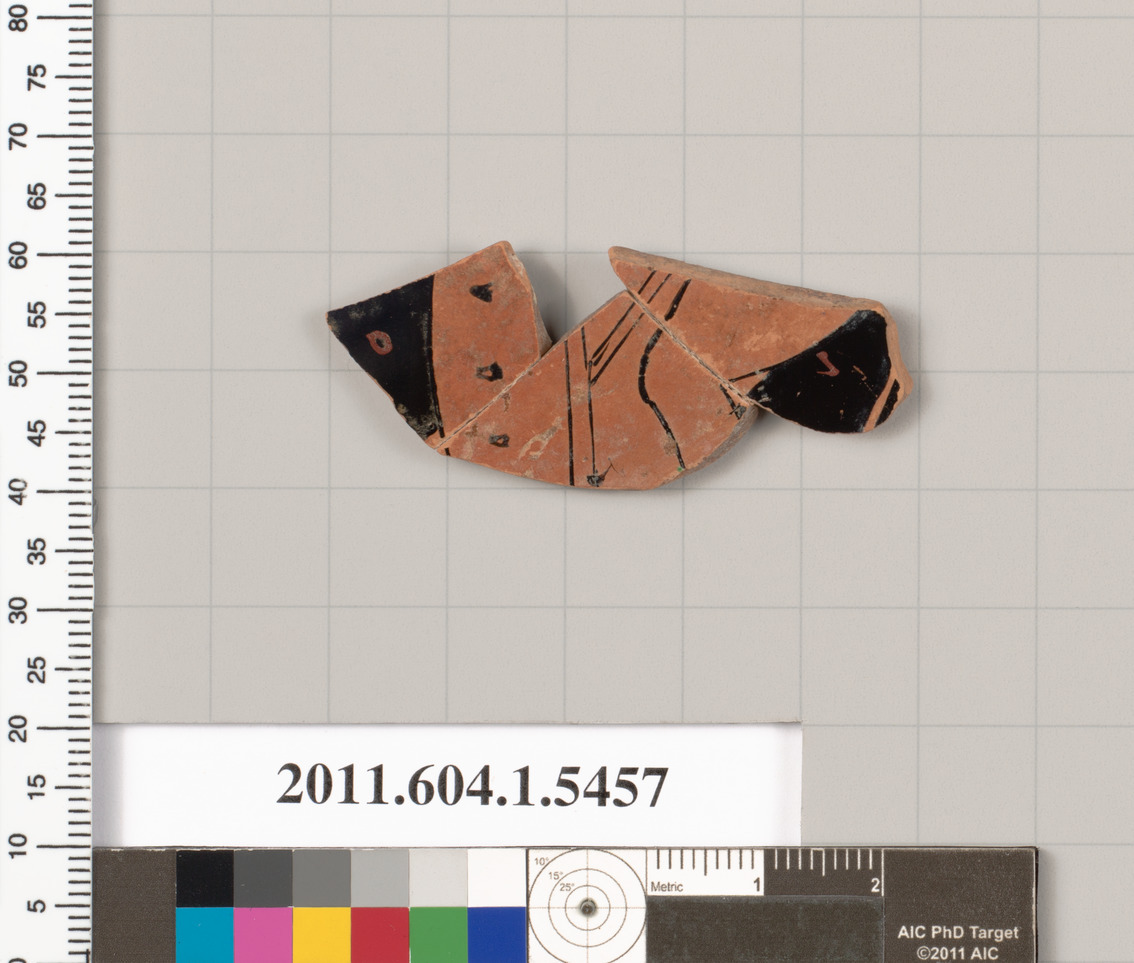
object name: kylix fragment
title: Terracotta fragment of a kylix (drinking cup)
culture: greek, attic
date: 500-490 BCE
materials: terracotta